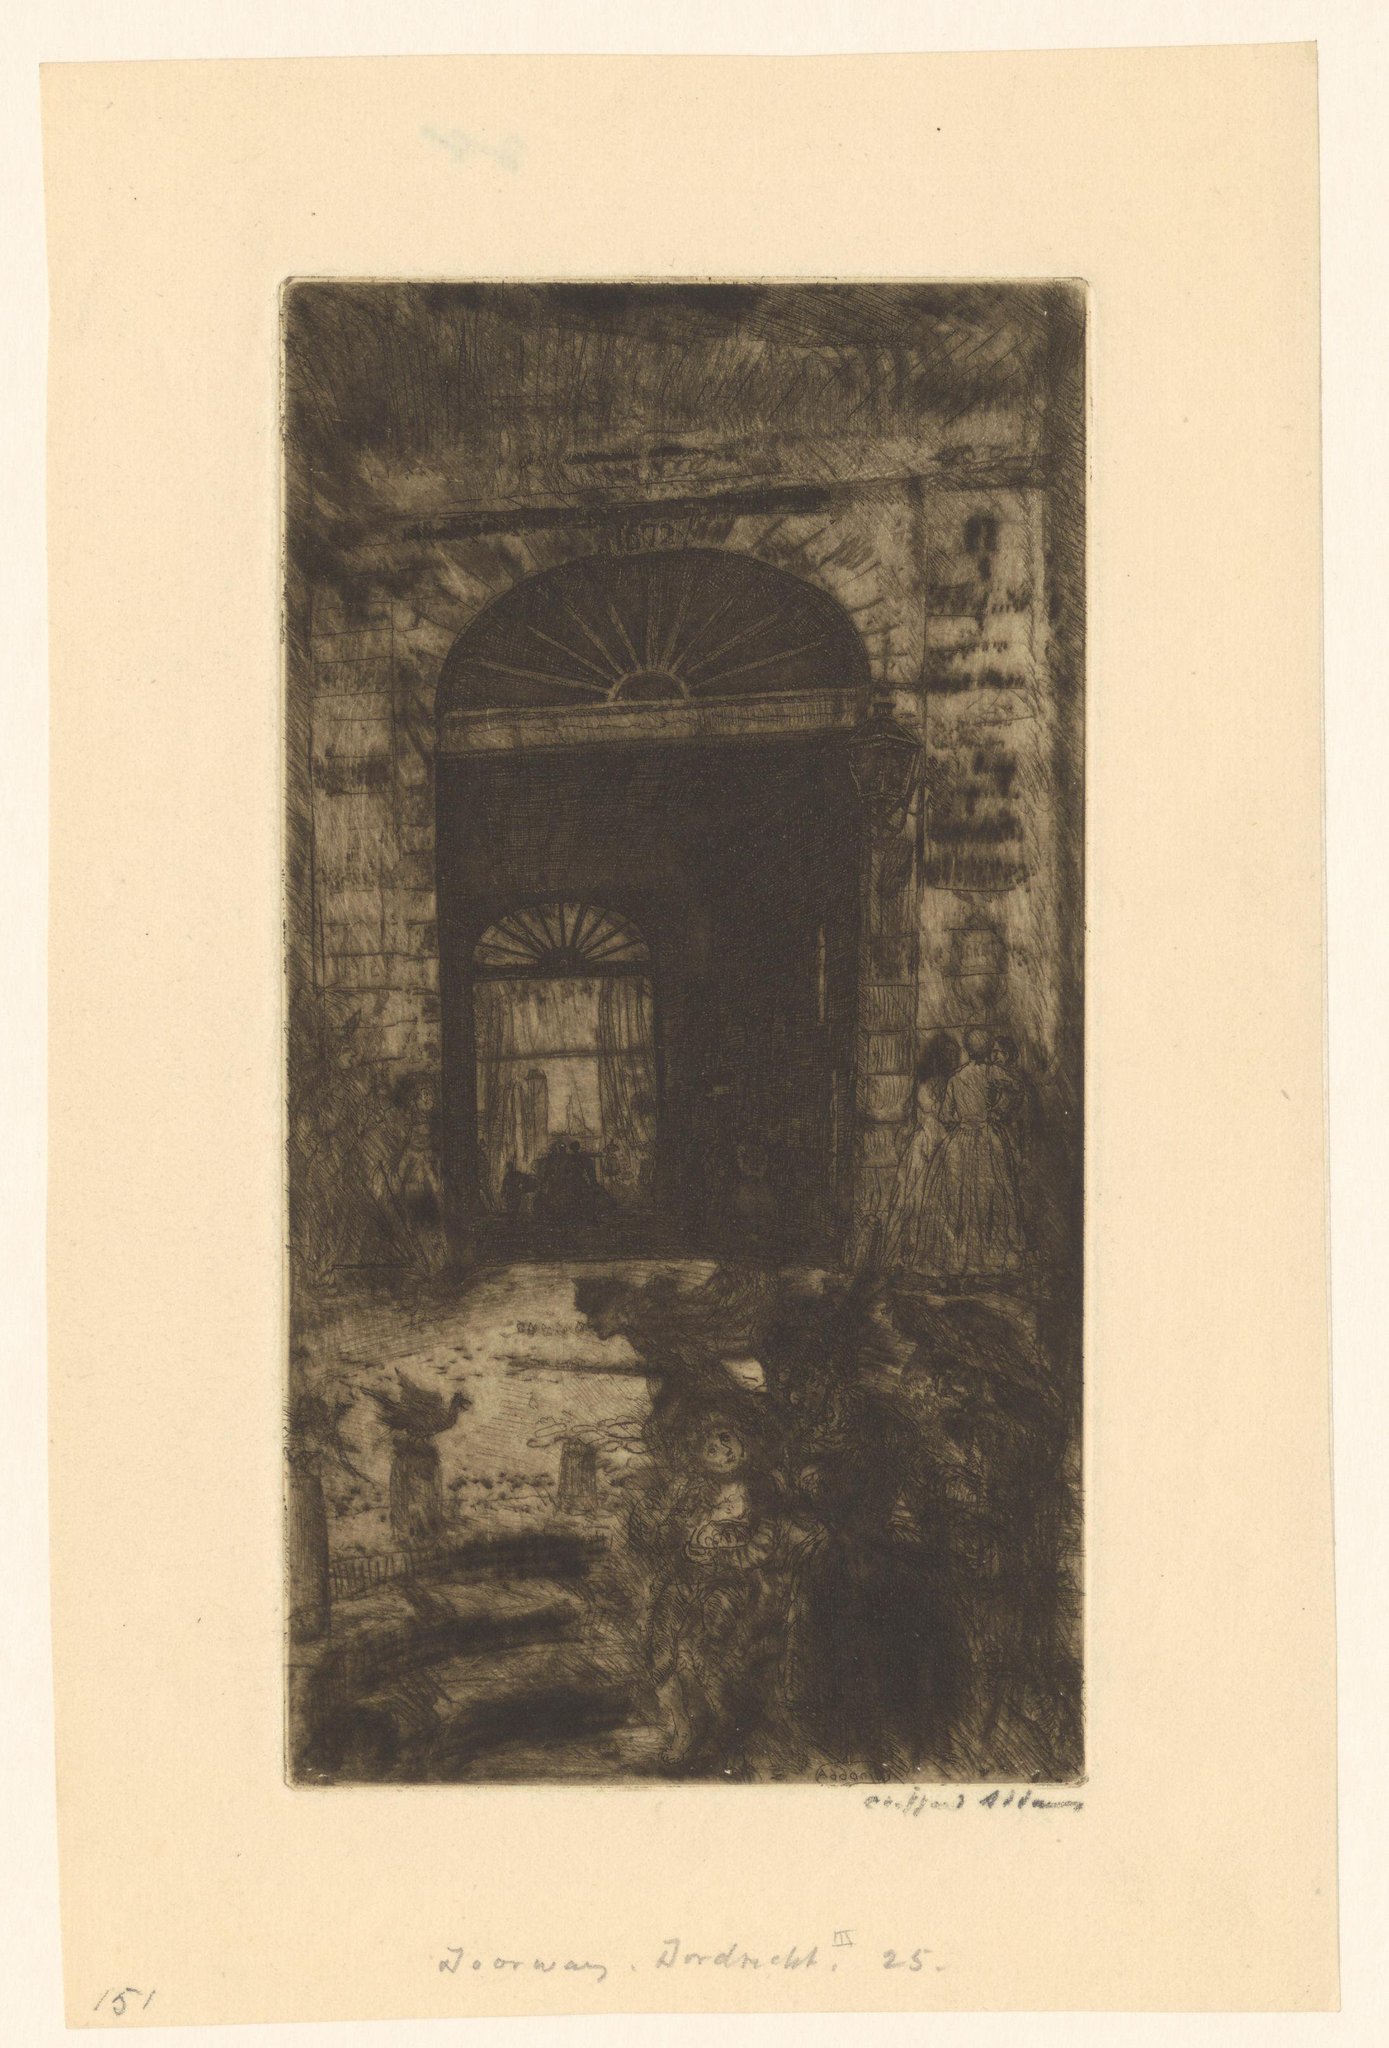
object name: print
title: Gezicht op de Blauwpoort te Dordrecht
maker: clifford addams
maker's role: painter, print maker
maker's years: 1876-1942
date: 1900-1920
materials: paper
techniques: drypoint, etching, intaglio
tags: gate, entrance, street (+ city(-scape) with figures, staffage), dordrecht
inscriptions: collector's mark: Lugt 2760, inscription: ‘Doorway, Dordrecht, 25’, collector's mark: Lugt 2228